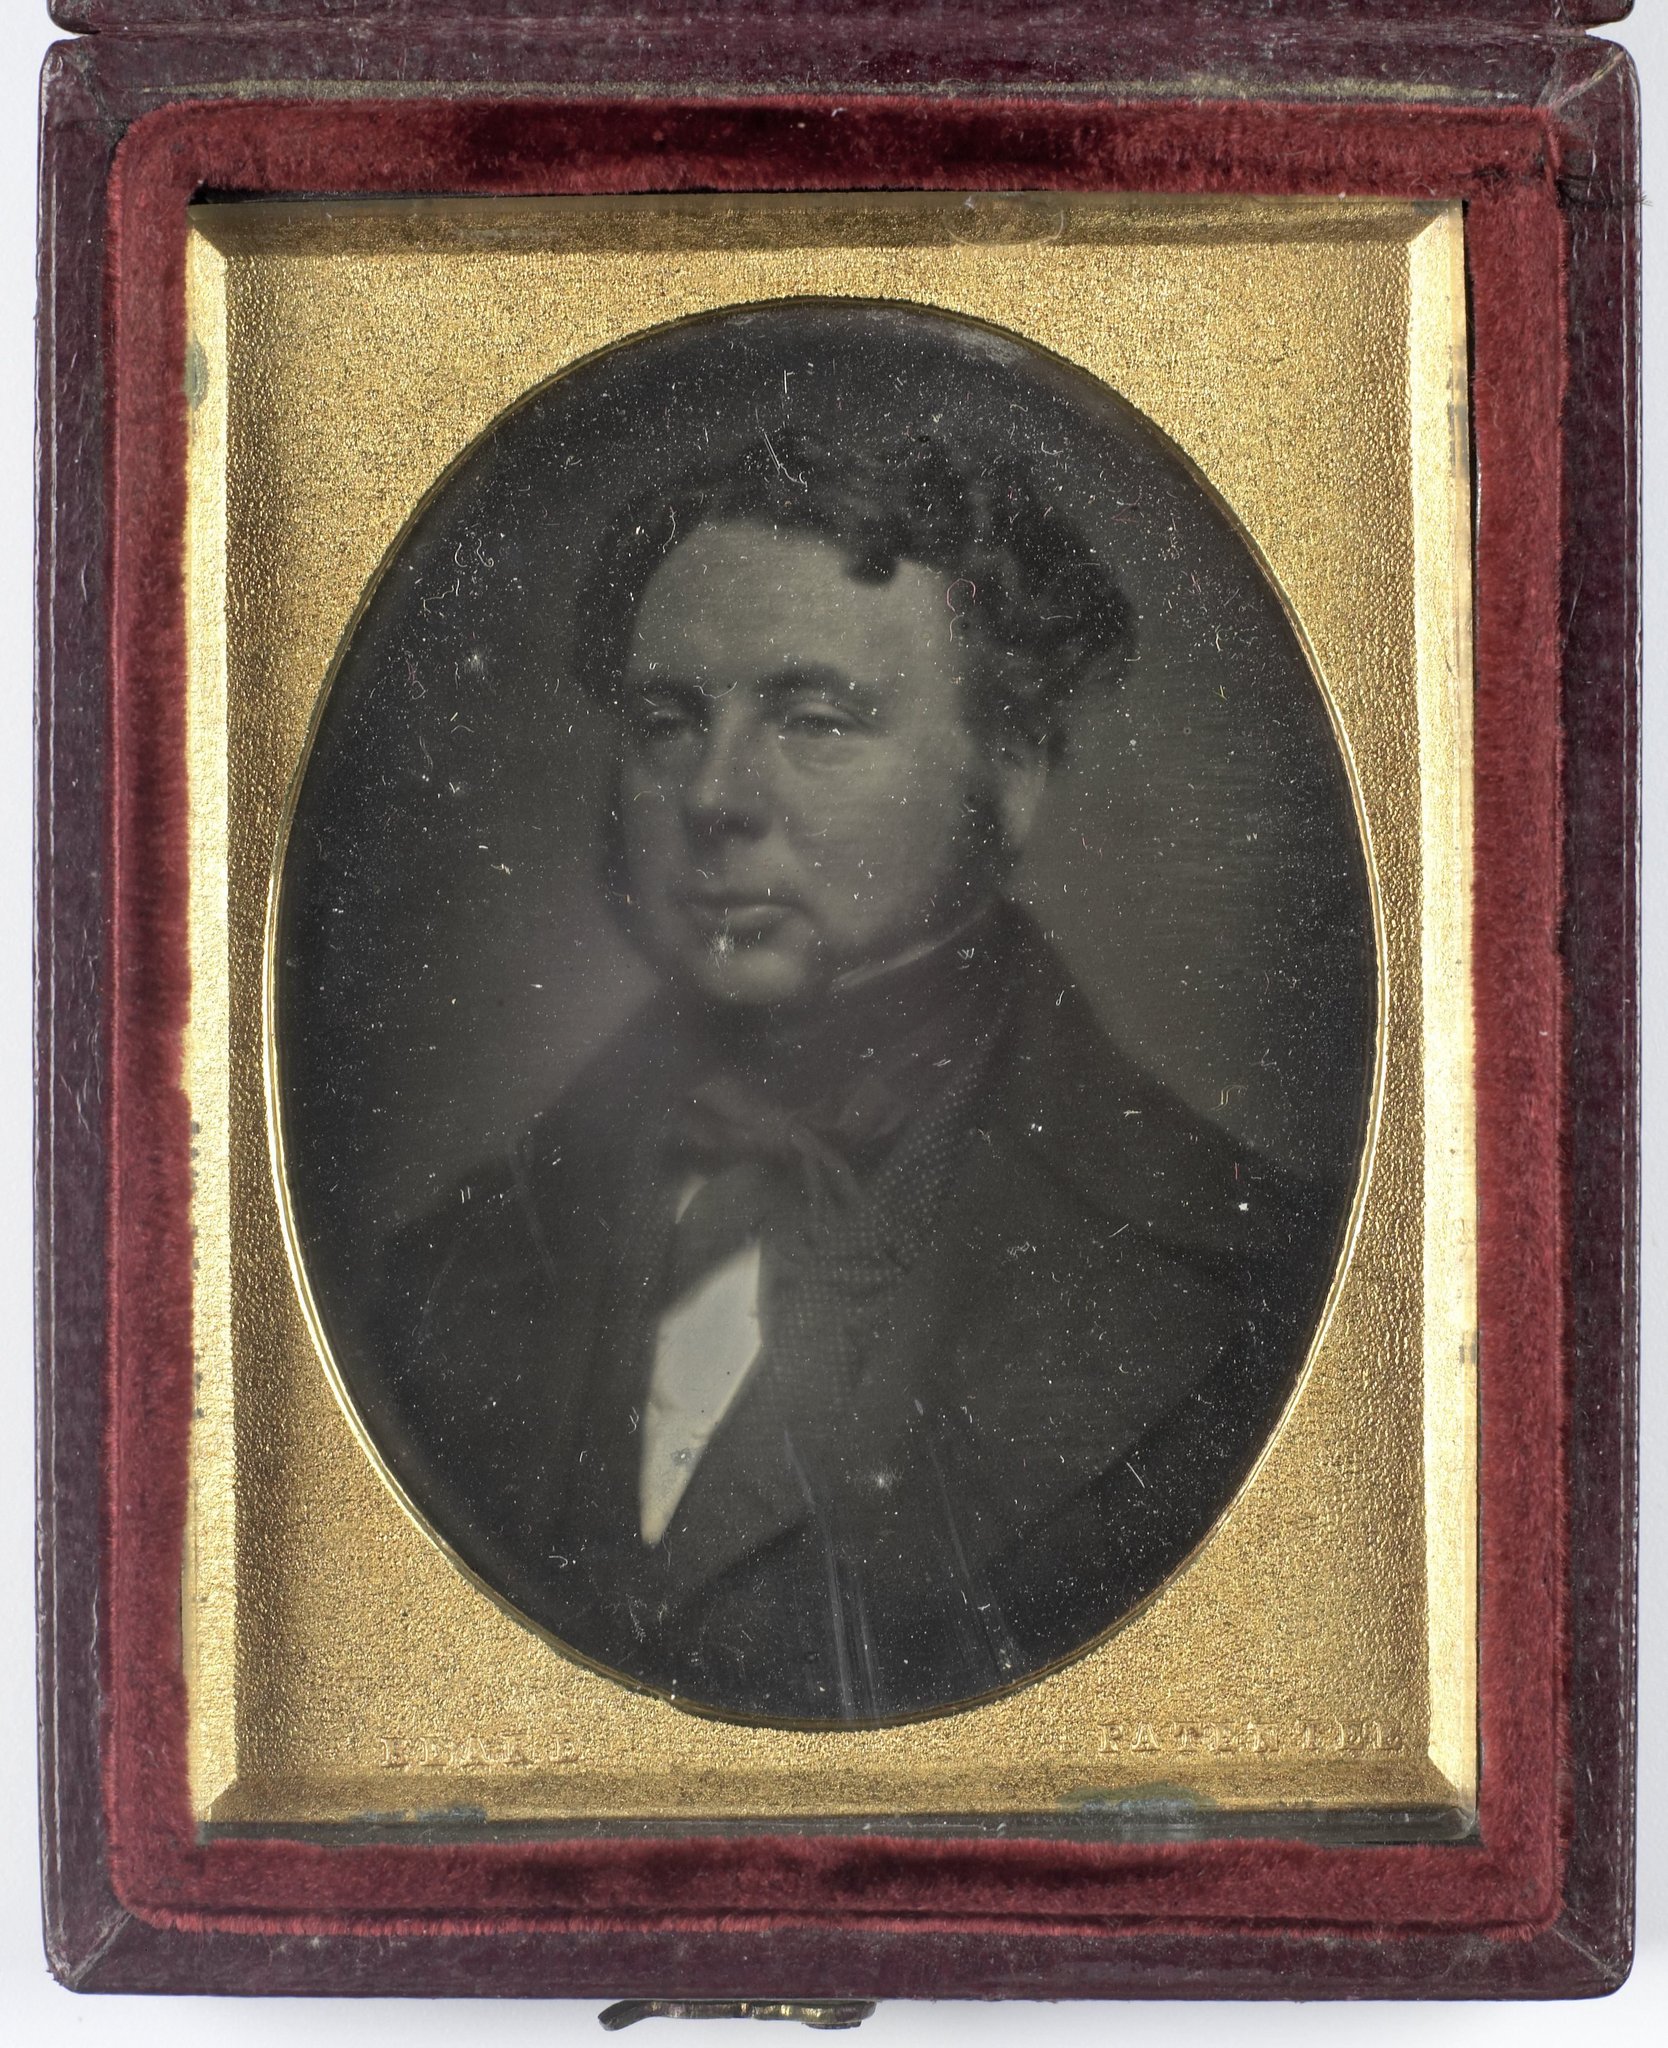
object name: photograph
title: Portret van een onbekende man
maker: richard beard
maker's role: fotograaf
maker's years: 1802-1888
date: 1841-1850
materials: copper, glass, leather, metal, velvet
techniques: daguerreotype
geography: london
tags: historical persons not known by name, london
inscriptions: inscription: ‘Beard/ Patented.’